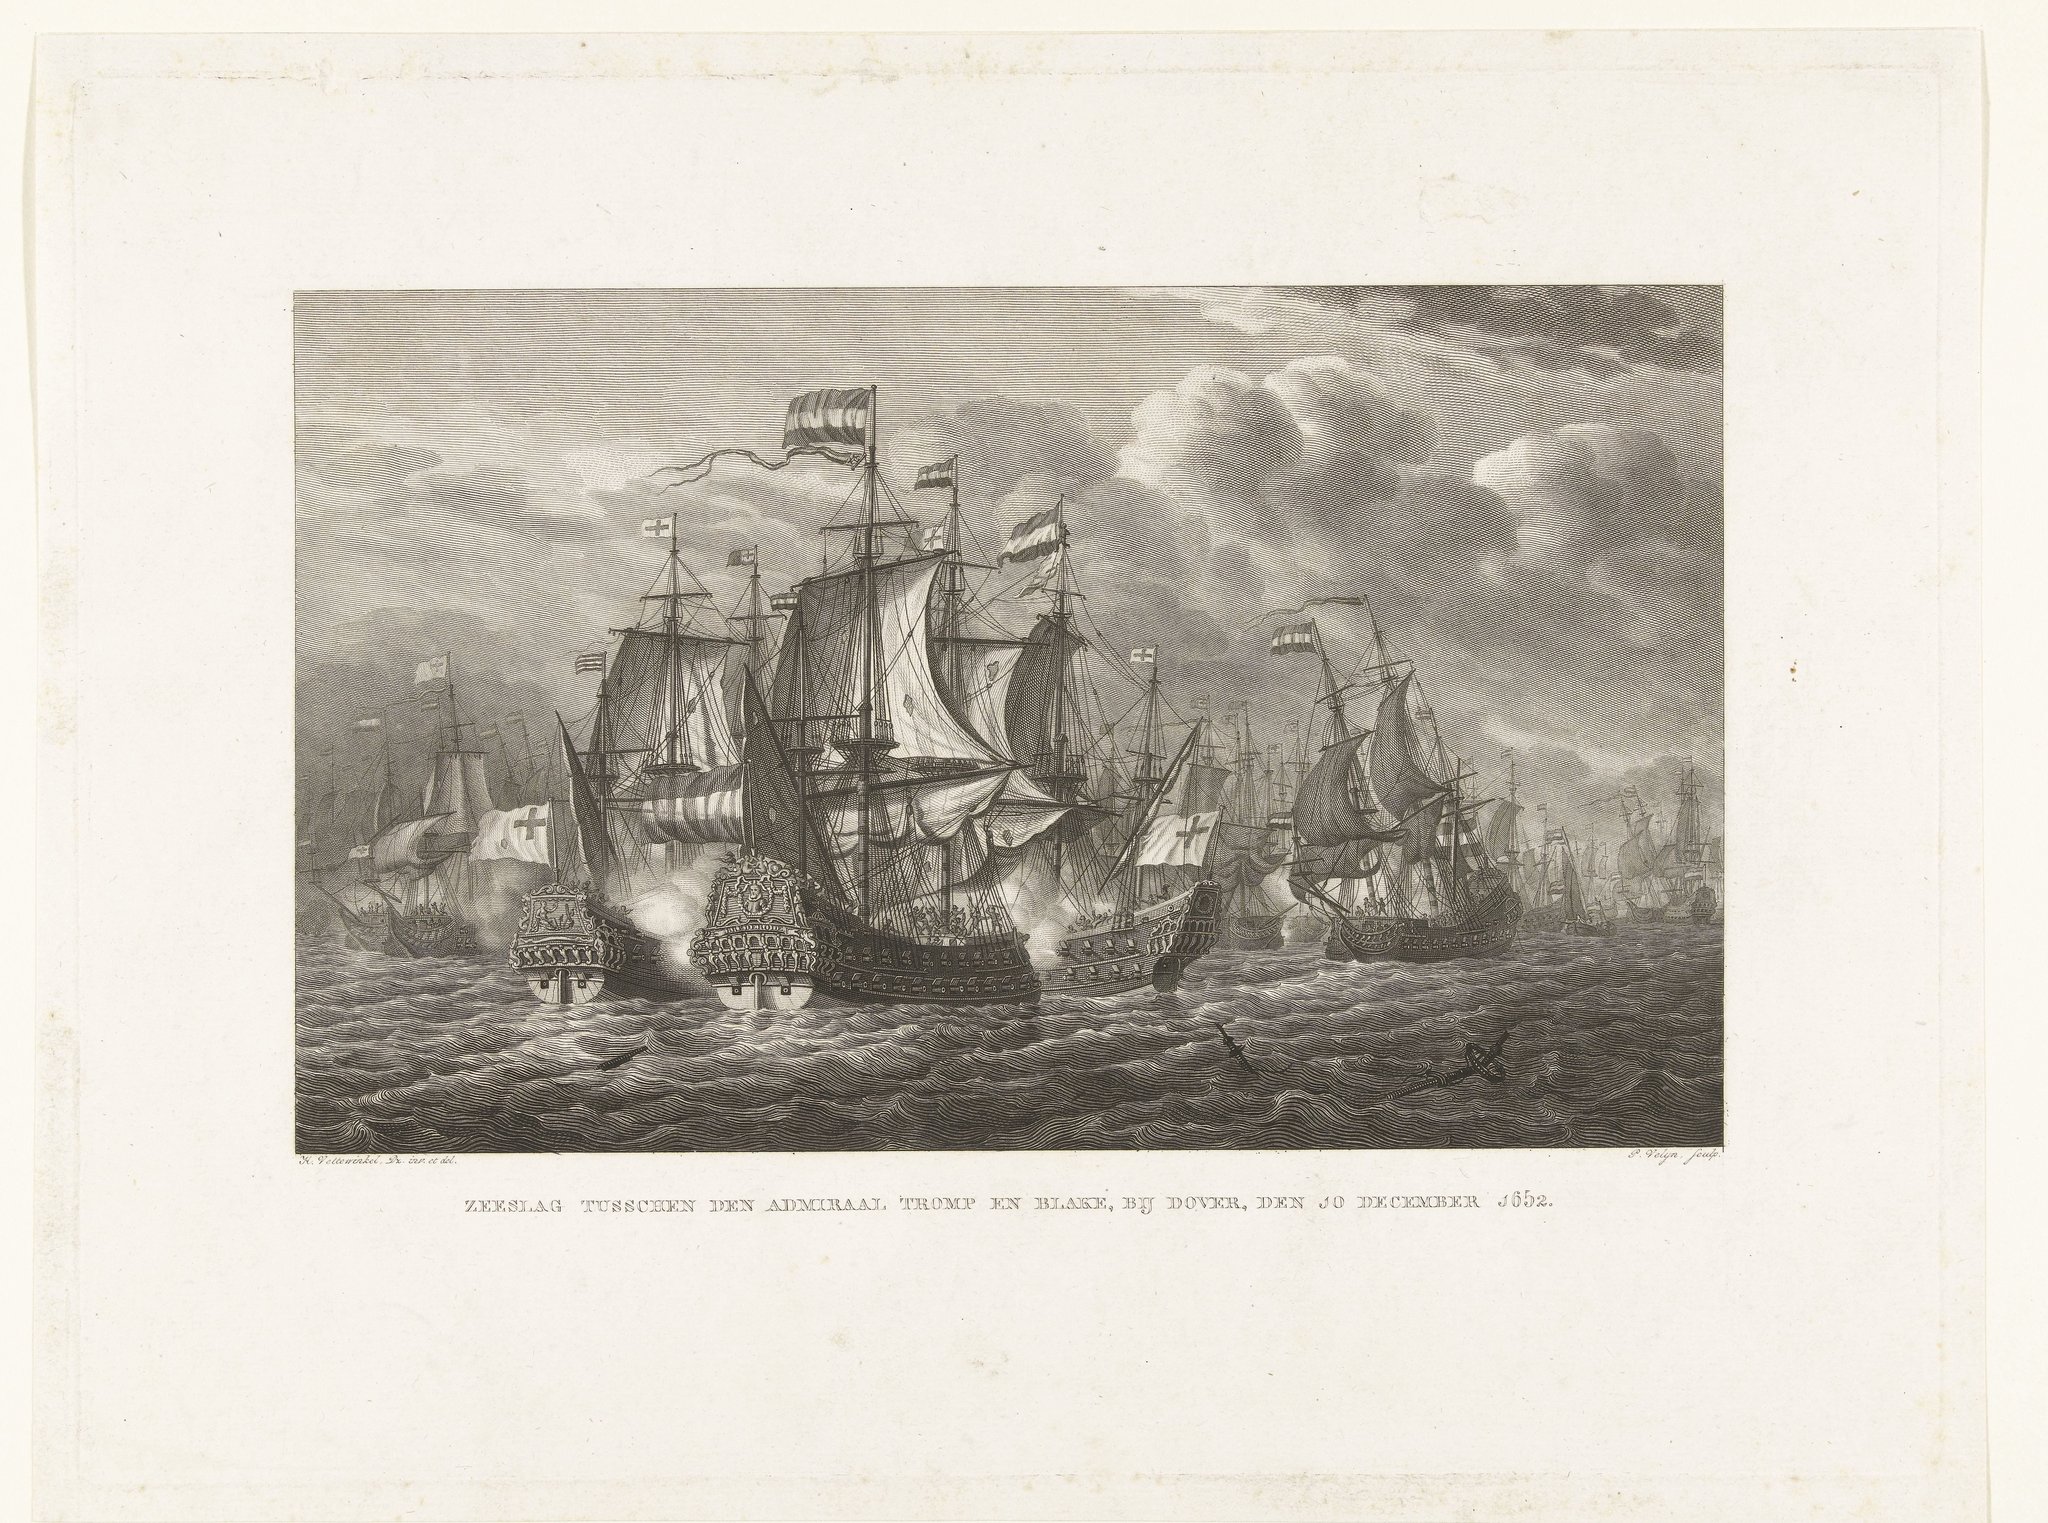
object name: print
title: Zeelsag tusschen den admiraal Tromp en Blake, bij Dover, den 10 december 1652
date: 1829-1834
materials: paper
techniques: engraving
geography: netherlands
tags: brielle, maarten harpertszoon tromp, battle (+ naval force), battle of dungeness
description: Zeeslag bij Dungeness (de Slag bij de Singels) voor de Engelse kust bij Dover in de Eerste Engelse Oorlog tussen de Staatse vloot onder Maarten Tromp en de Engelse vloot onder Robert Blake, 10 december 1652. Centraal het gevecht van het admiraalsschip de Brederode van Tromp in gevecht met de Engelse schepen Bonaventure en de Rozenkans. Van rechts schiet het schip van vice-admiraal Johan Evertsen te hulp. Bij de plaat behoort een tekstblad.